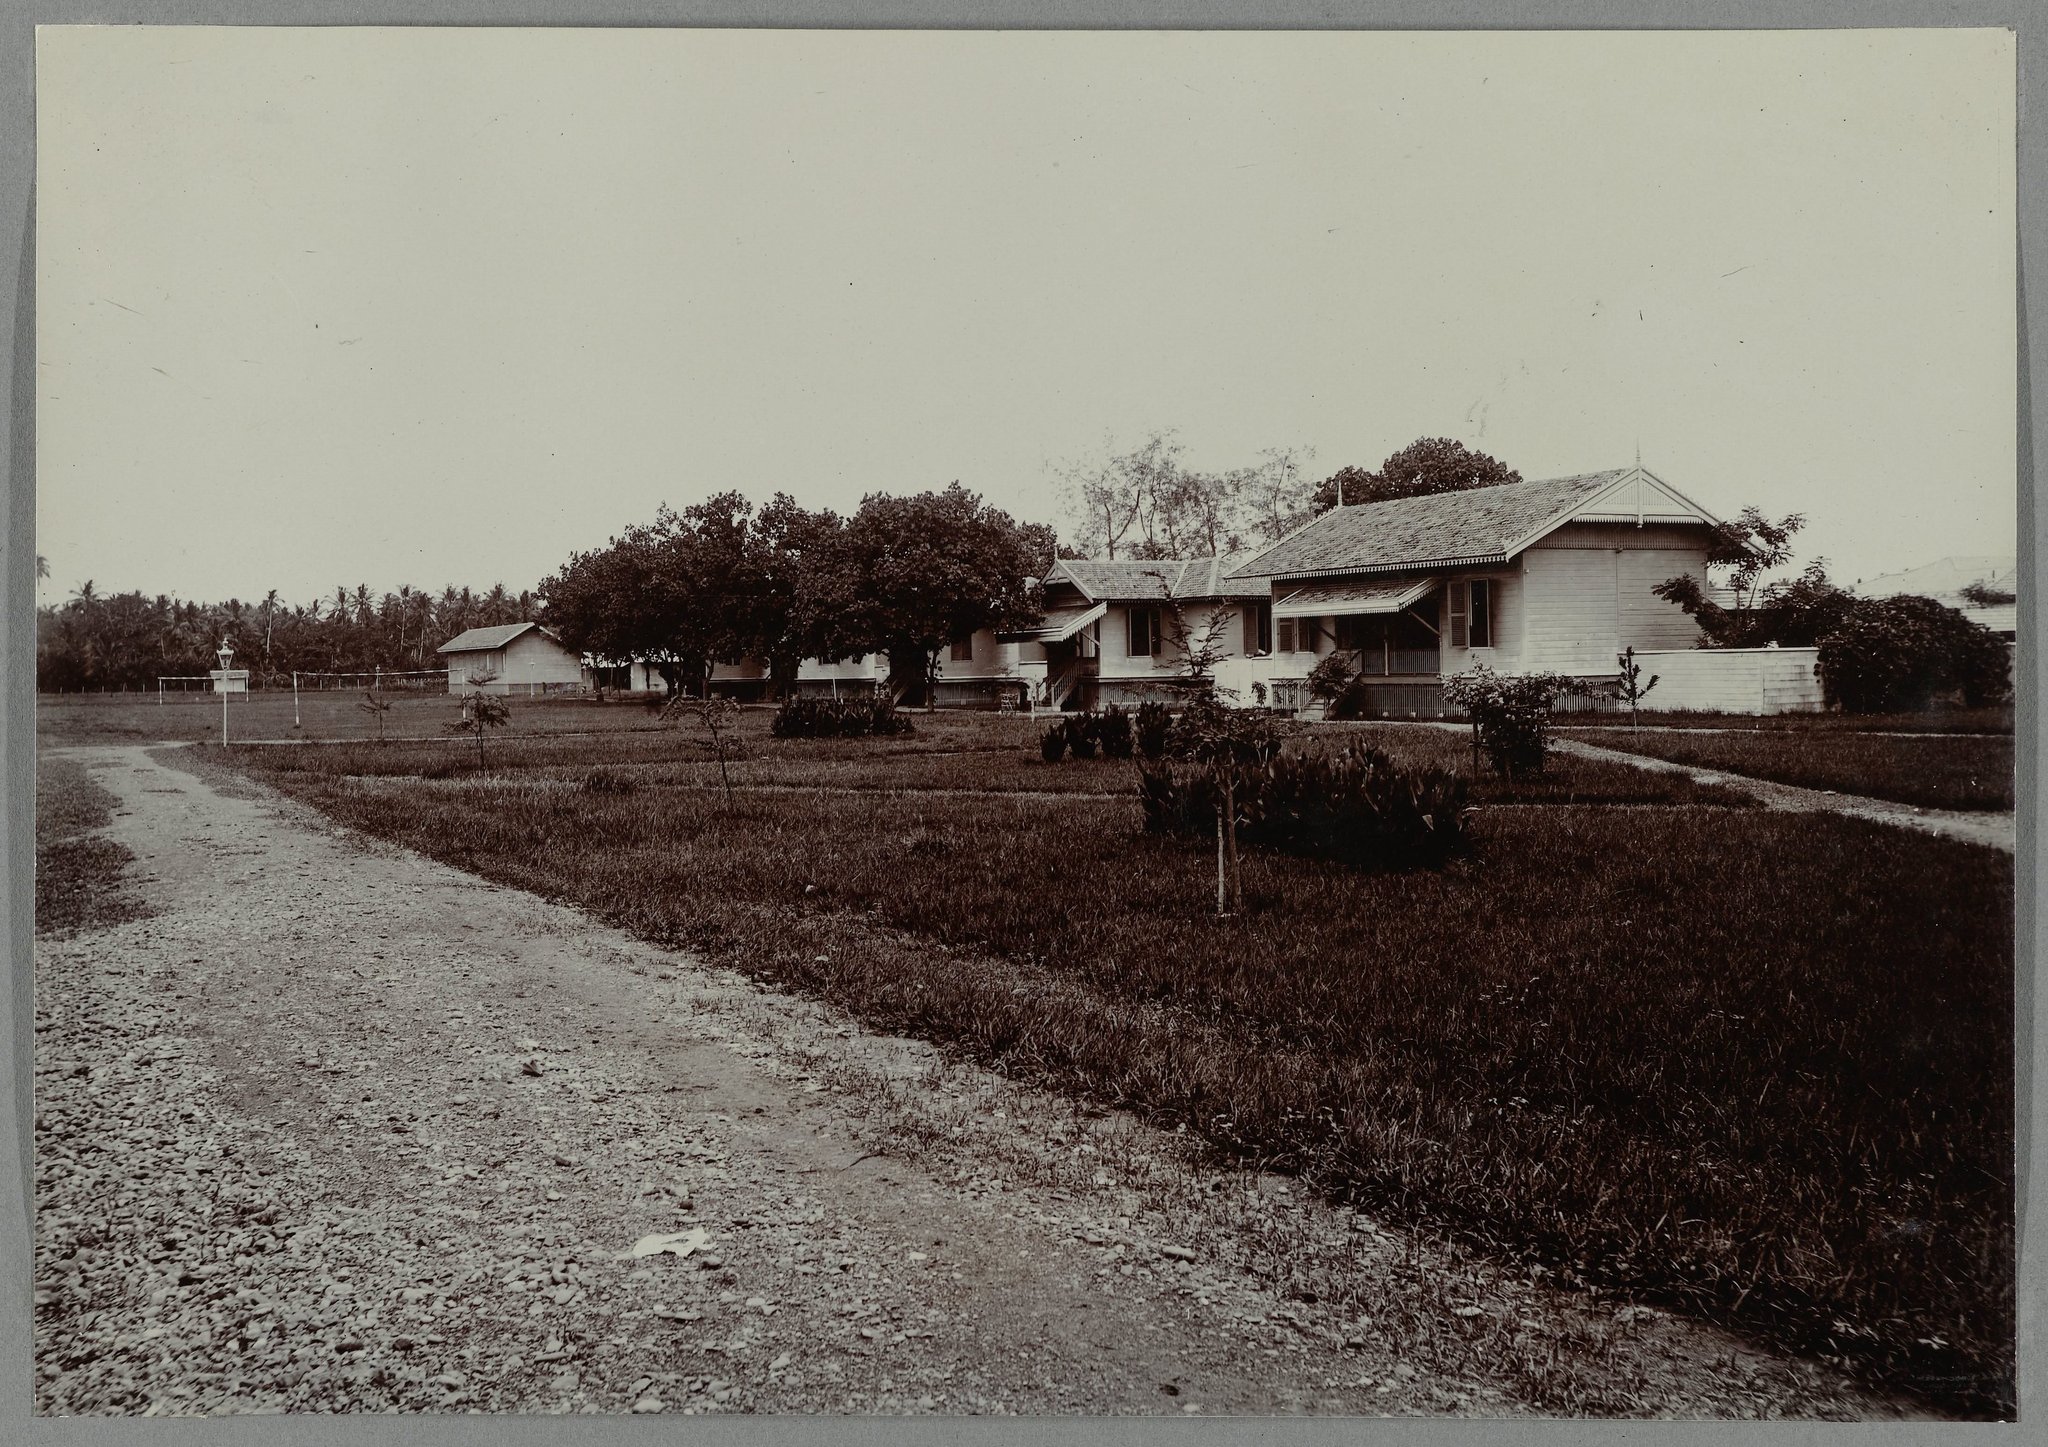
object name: photograph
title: Huizen in Bireuen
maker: Anonymous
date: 1903-1913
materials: photographic support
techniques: photography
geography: north sumatra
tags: arnhem, the hague, albertus dominicus laman trip, landscapes in tropical and sub-tropical regions, village, road, path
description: Na de expedities naar de Gajo- en Alaslanden o.l.v. Van Daalen (eerste tocht in 1901), werd hij in 1903 belast met voorbereiding van permanente vestiging van Nederlands gezag. Aanleg van een weg van de Noordkust naar het binnenland was hierbij van groot belang. Deze zgn. Gajoweg werd aangelegd tussen 1903 en 1914, van Bireuen aan de kust naar Takinguen aan het bergmeer Danau Lauttawar, totale lente 104 km.